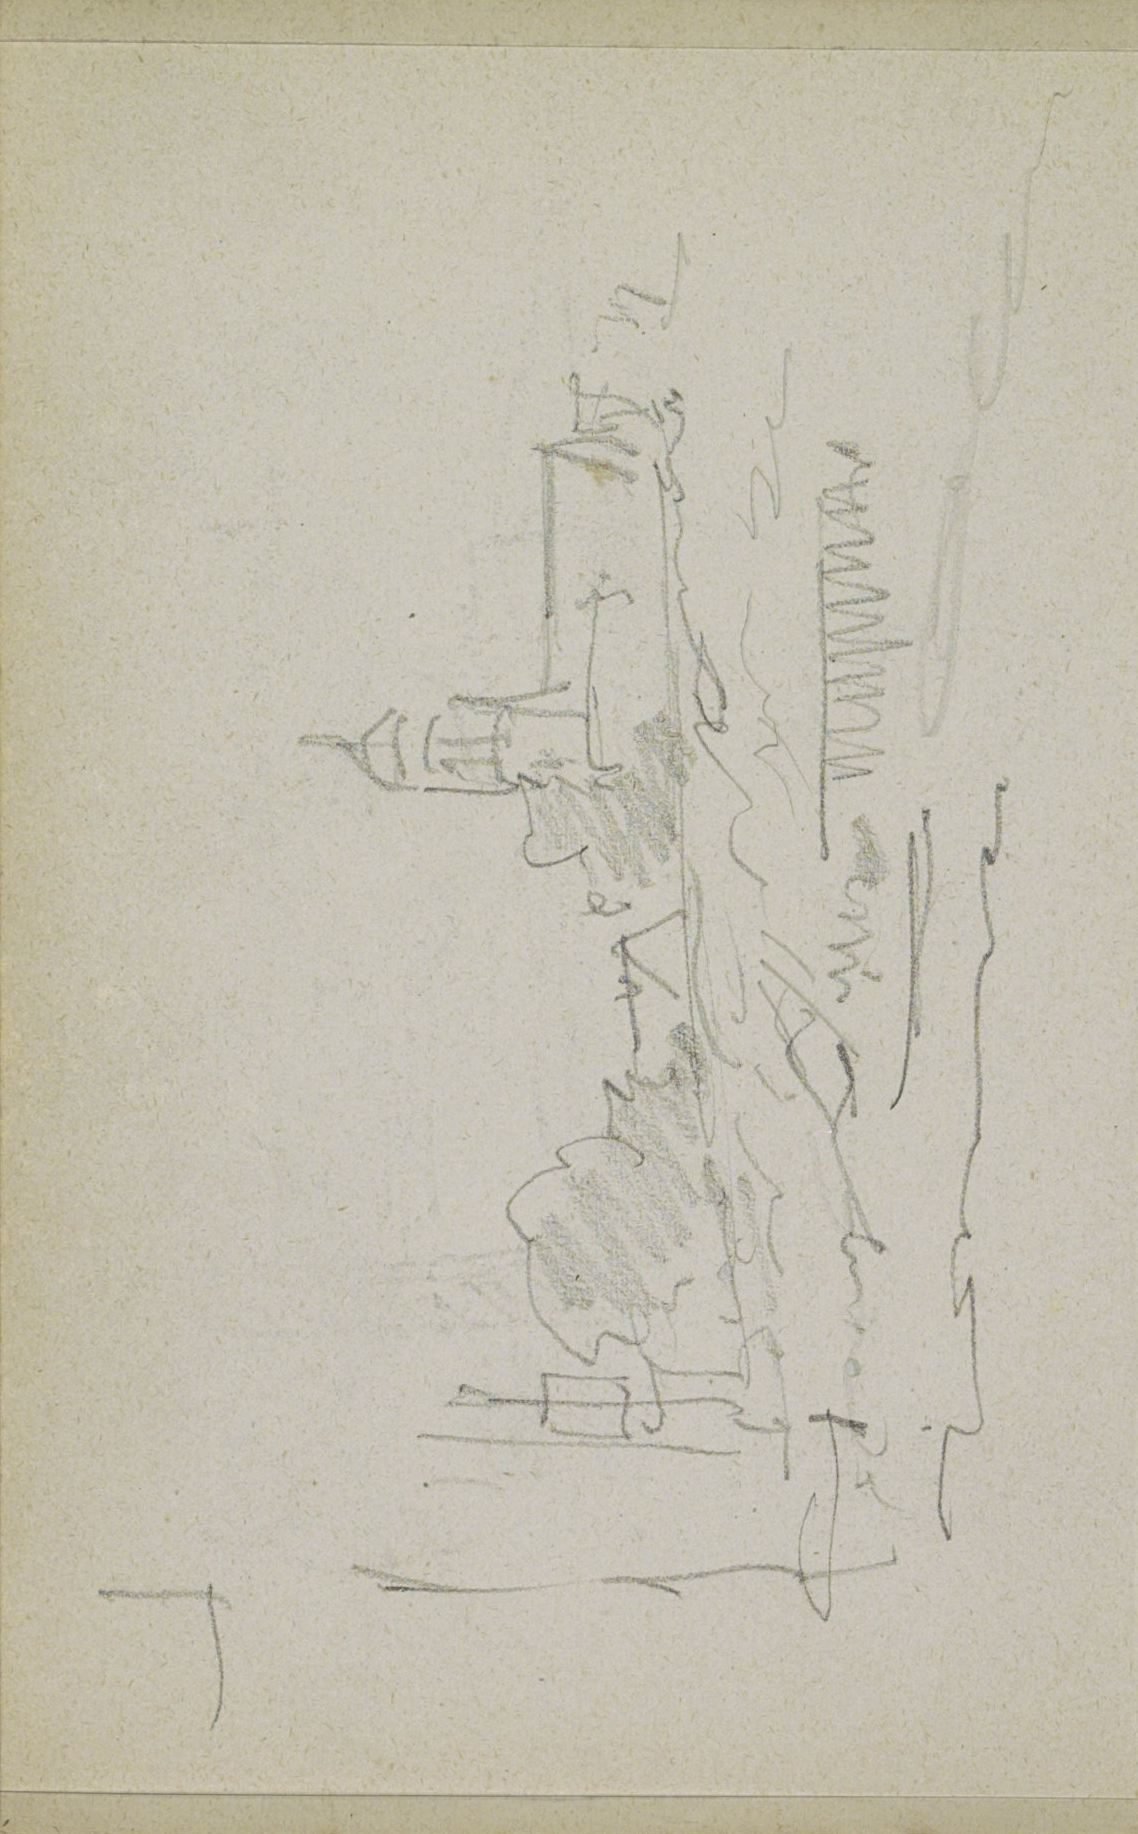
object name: sketchbook leaf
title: Stadsgezicht met een kerk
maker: adrianus eversen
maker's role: draughtsman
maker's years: 1818-1897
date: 1828-1897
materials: paper, pencil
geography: netherlands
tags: city-view, and landscape with man-made constructions, church (exterior)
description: Stadsgezicht met een kerk. Blad 13 verso uit een schetsboek met 58 bladen.